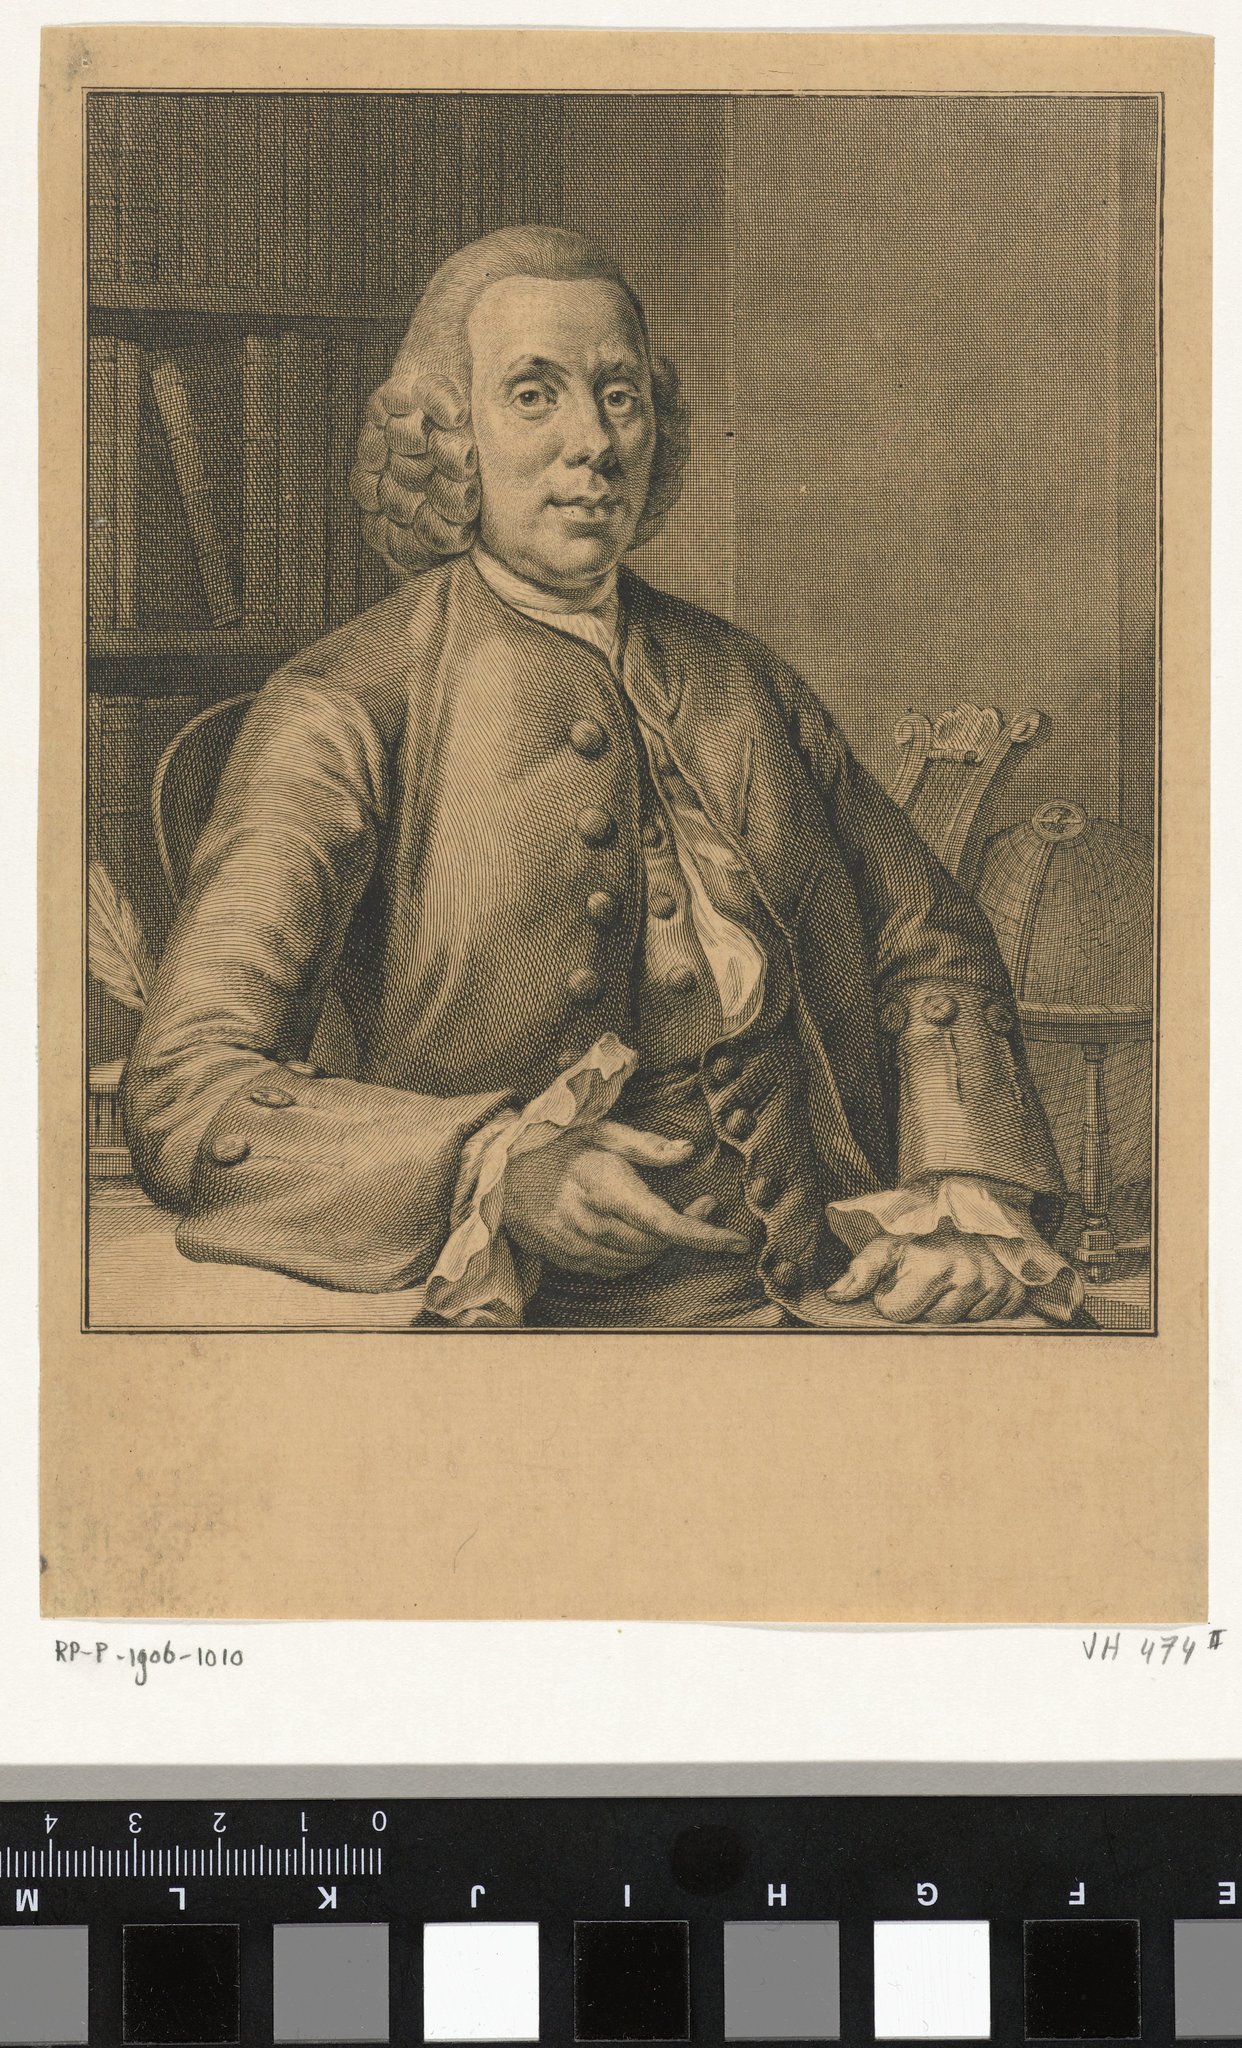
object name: print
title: Portret van Nicolaas Simon van Winter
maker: jacob houbraken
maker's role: draughtsman, print maker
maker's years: 1698-1780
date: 1771-1773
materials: paper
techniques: engraving, etching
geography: amsterdam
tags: amsterdam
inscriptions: collector's mark: Lugt 2228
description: Portret van de dichter Nicolaas Simon van Winter.